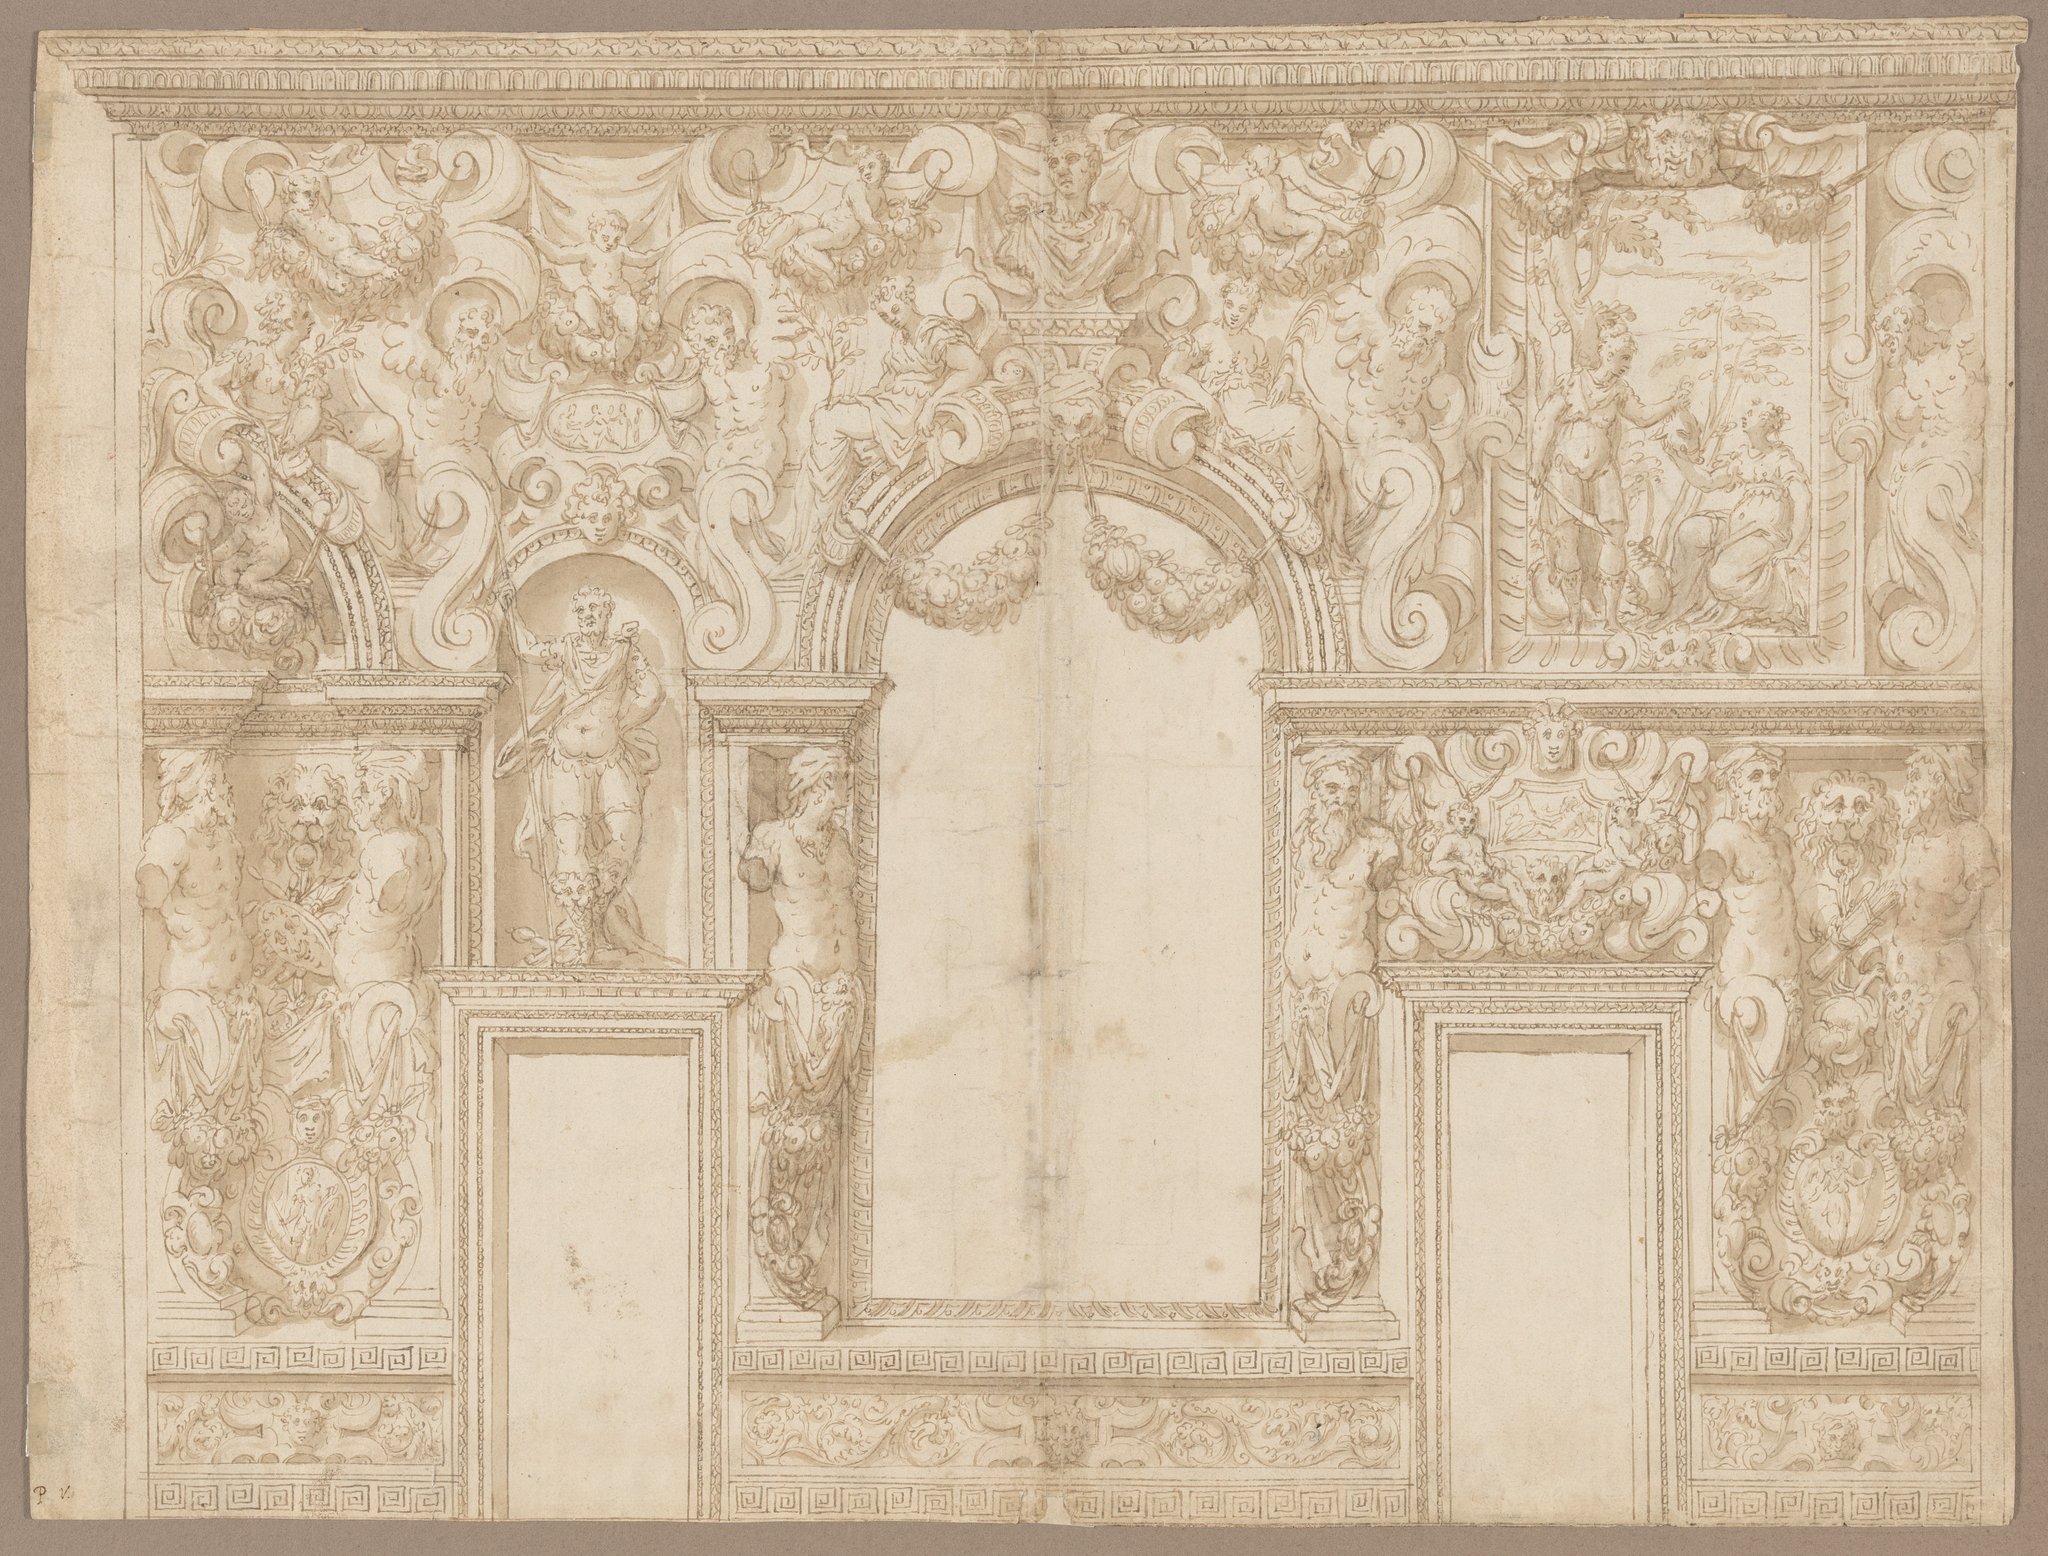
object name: drawing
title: Design for the Decoration of a Palace Wall (Veronese Palazzo?)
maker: alessandro vittoria (alessandro vittoria di vigilio della volpa)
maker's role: artist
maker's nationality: italian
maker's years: 1525-1608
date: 1550-1570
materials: chalk, ink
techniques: brush, pen, wash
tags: architecture